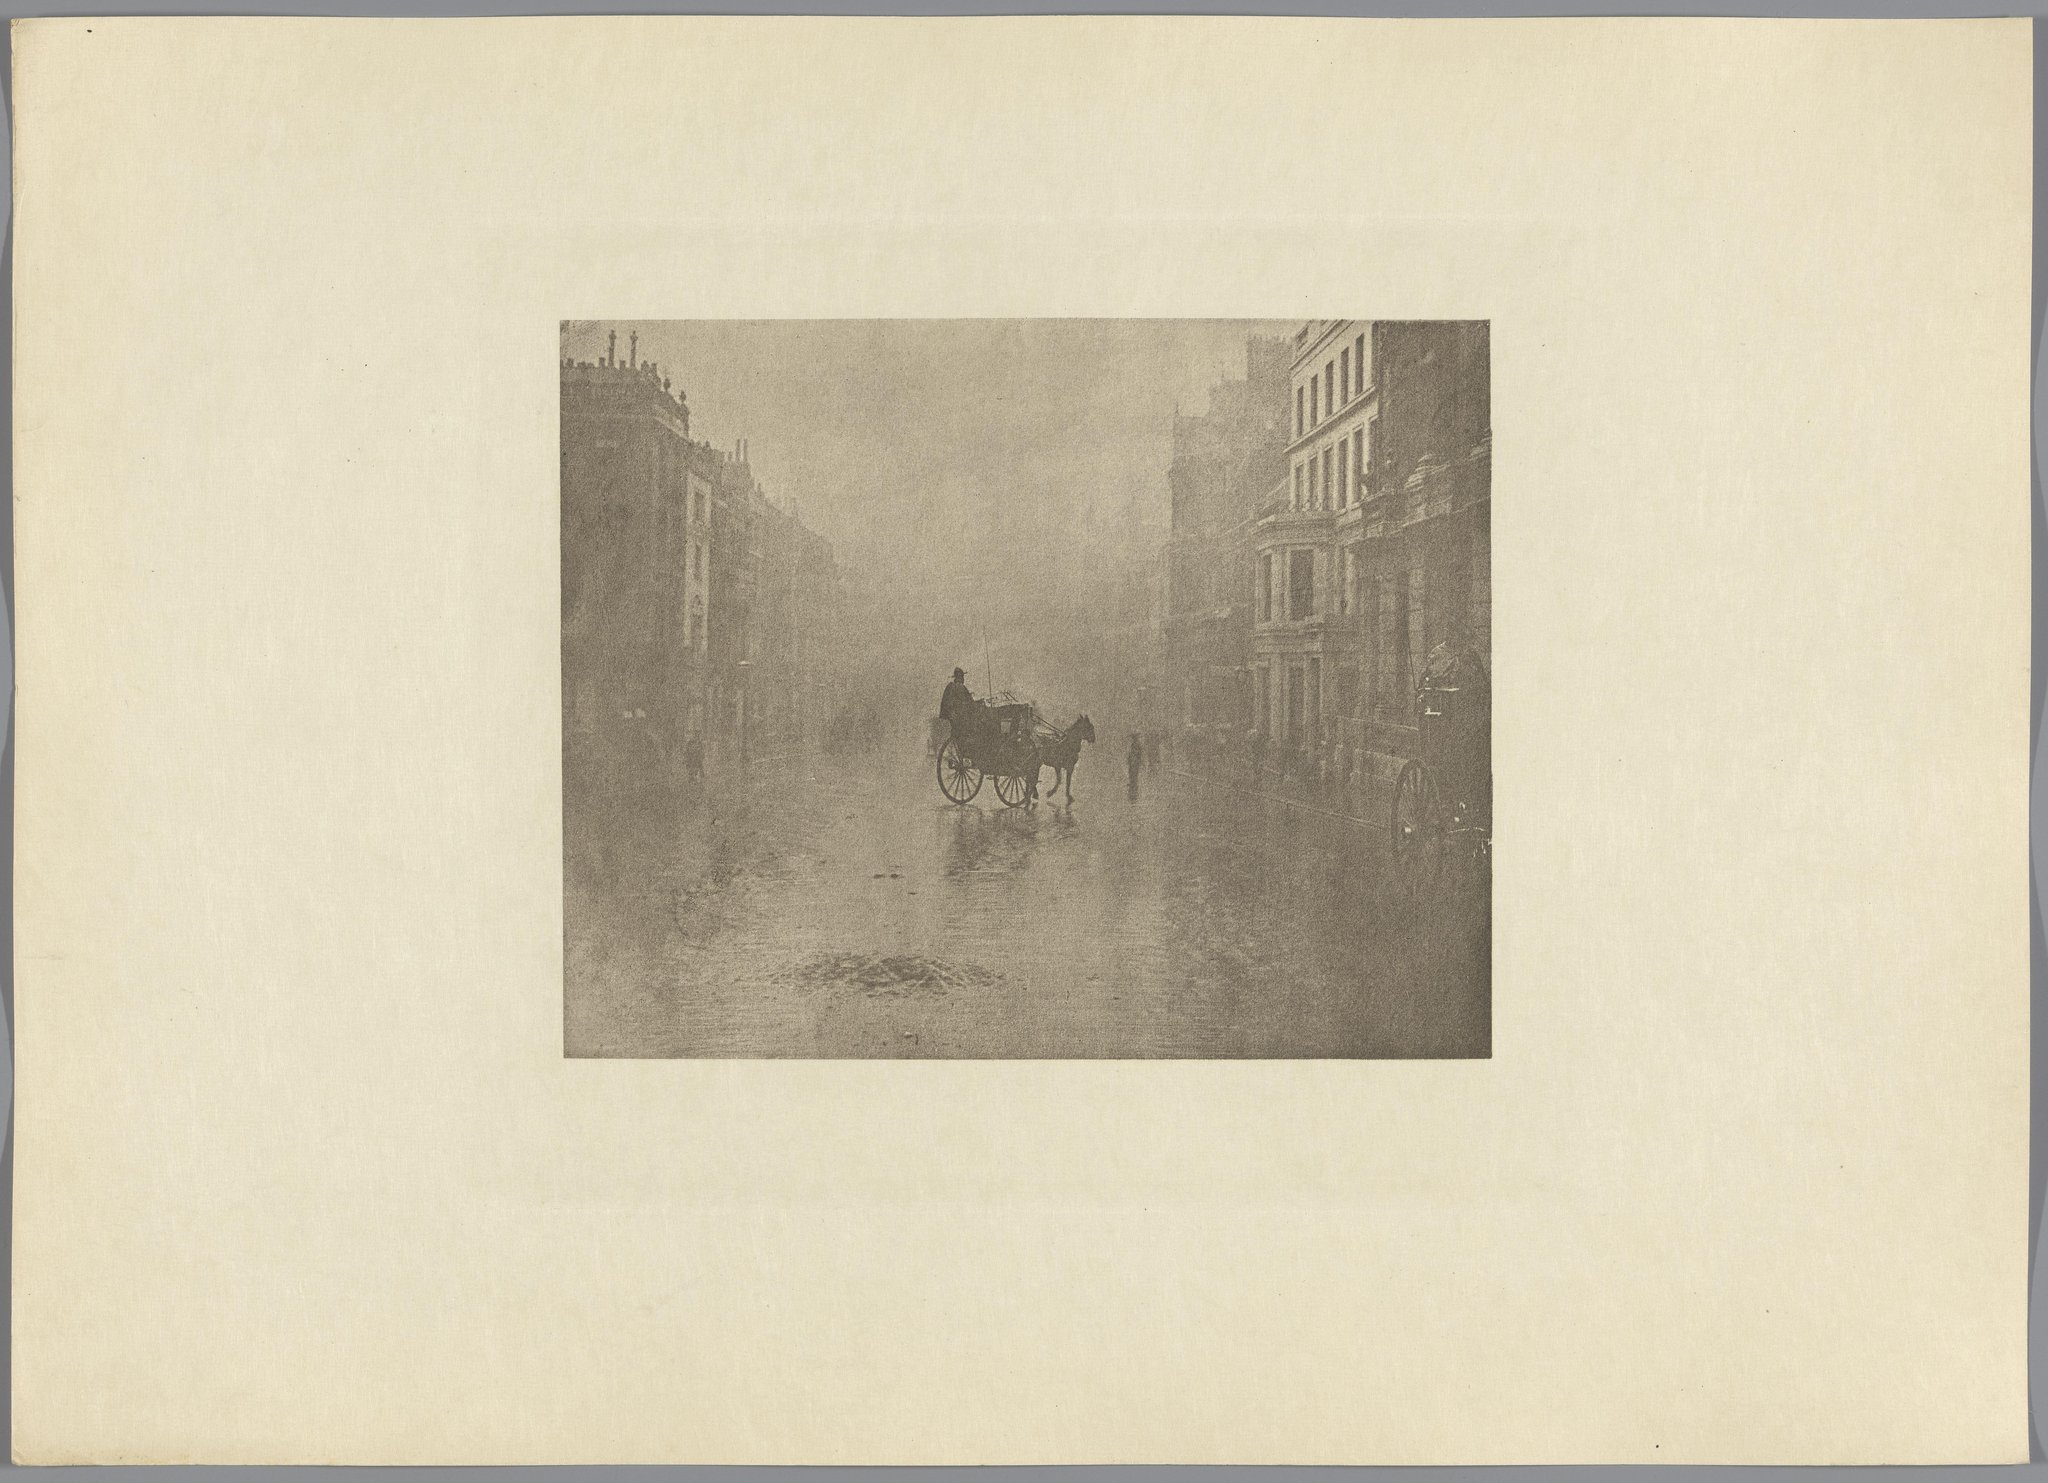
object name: photomechanical print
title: Koets op straat in Londen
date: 1891-1896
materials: paper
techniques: photoaquatint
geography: london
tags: street, two-wheeled vehicle drawn by one animal, mist, fog, london